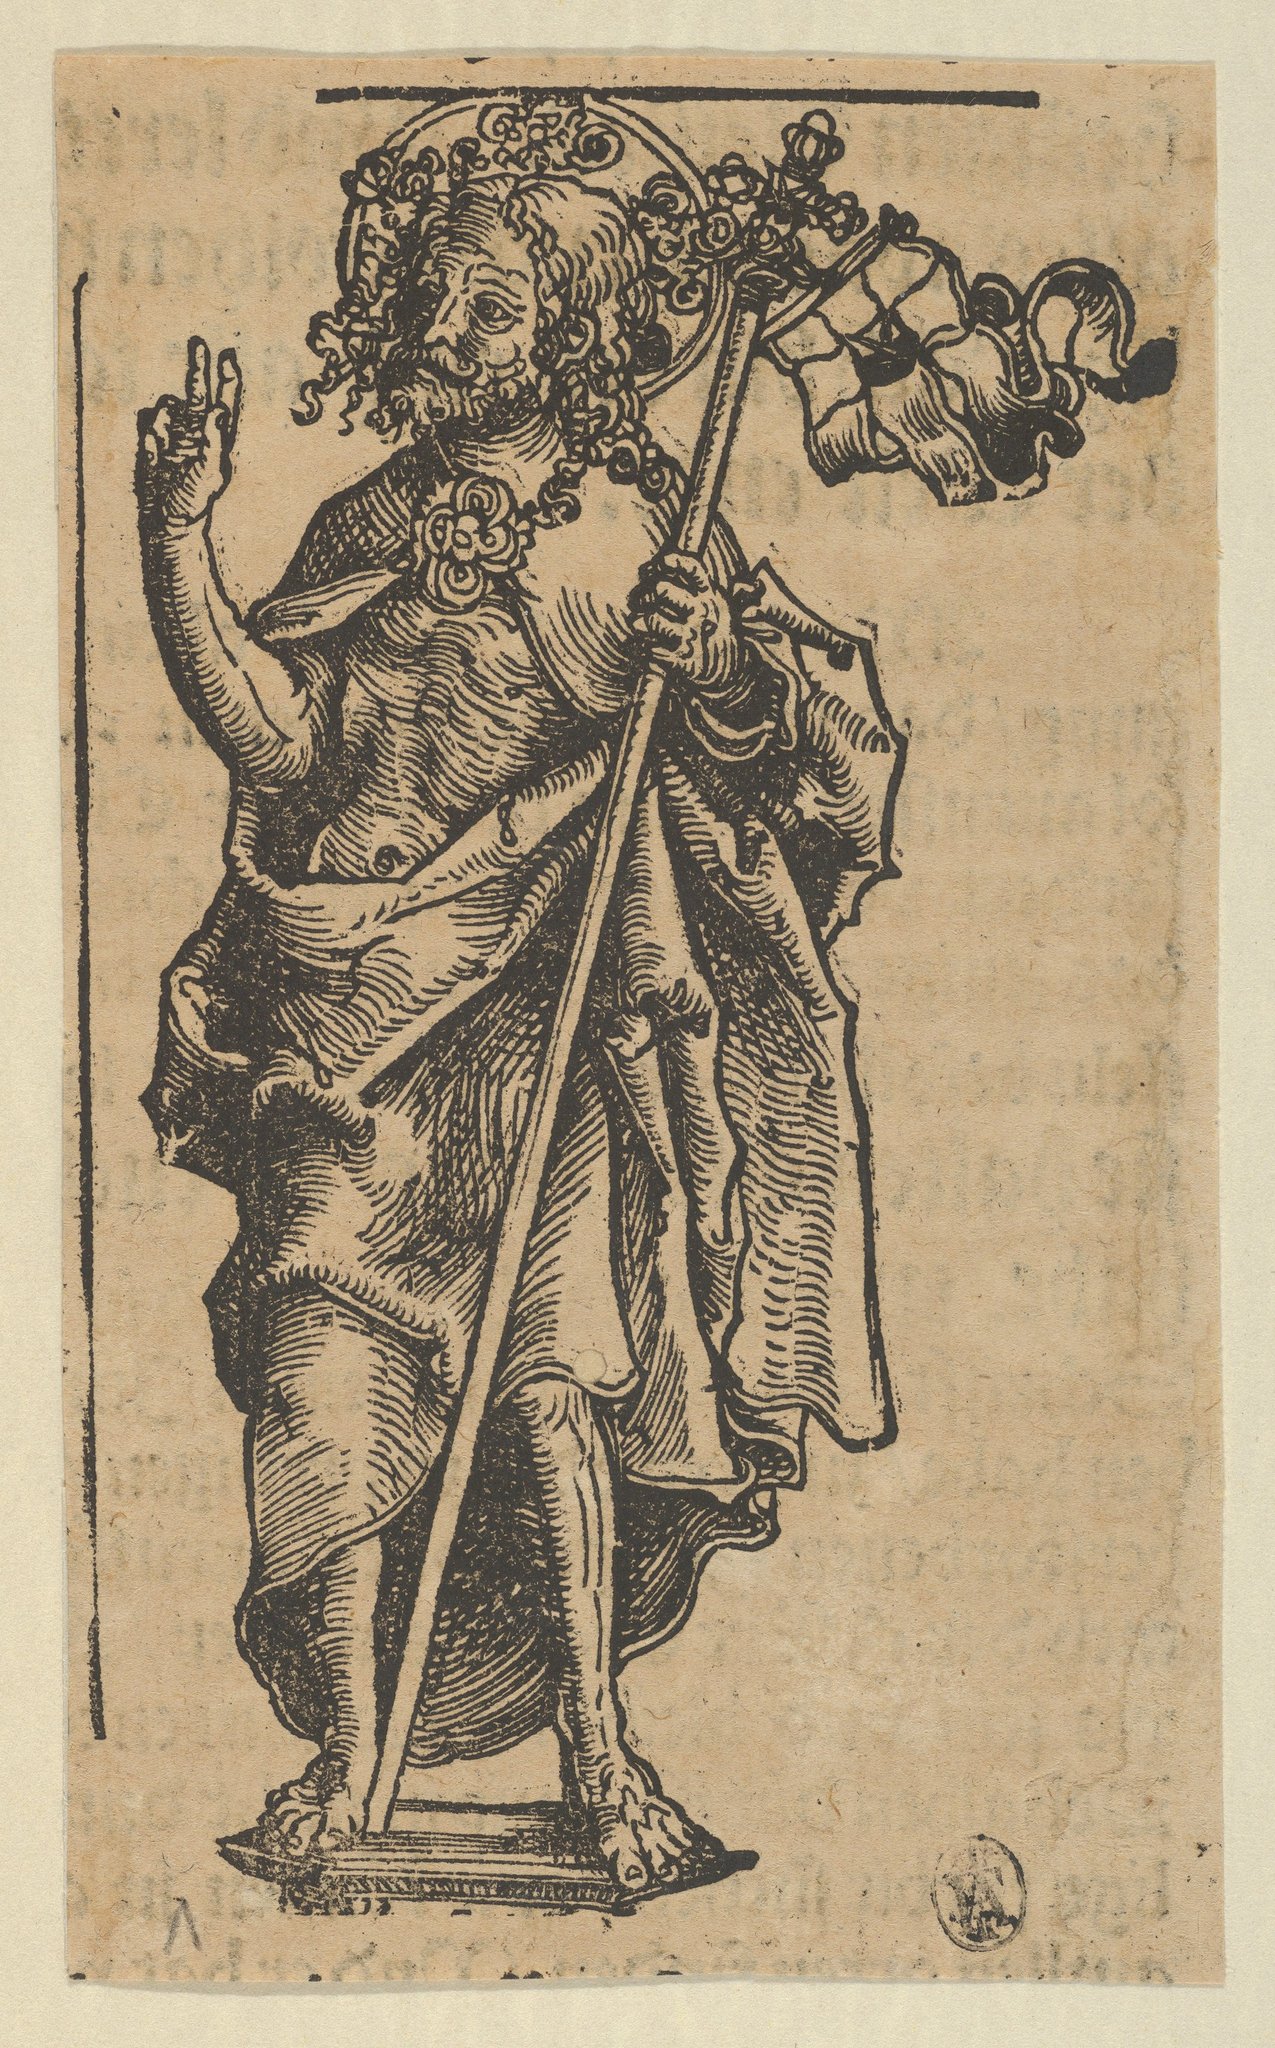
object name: print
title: Silver Statuette of the Risen Christ, from the "Wittenberg Reliquaries"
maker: lucas cranach the elder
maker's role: artist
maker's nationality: german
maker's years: 1472-1553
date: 1472-1553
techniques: woodcut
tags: christ